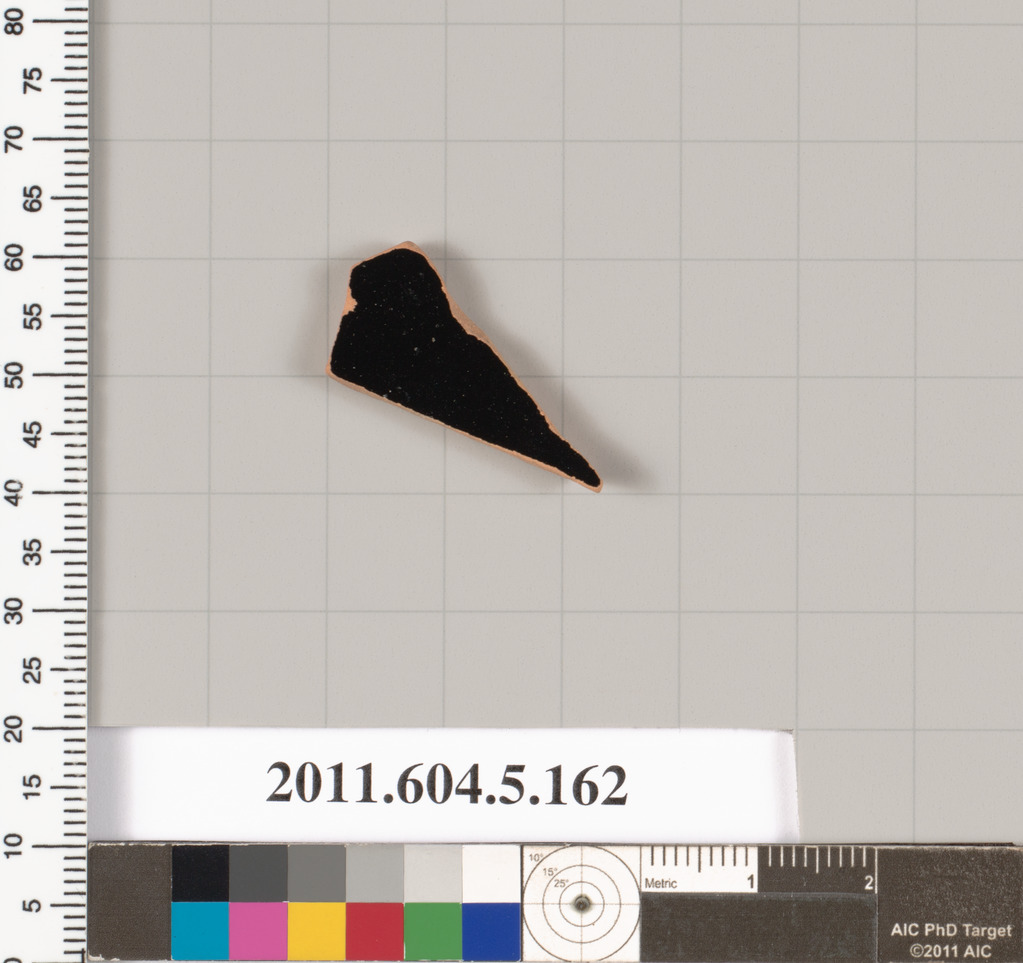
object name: kylix fragment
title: Terracotta fragment of a kylix (drinking cup)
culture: greek, attic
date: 600-401 BCE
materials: terracotta